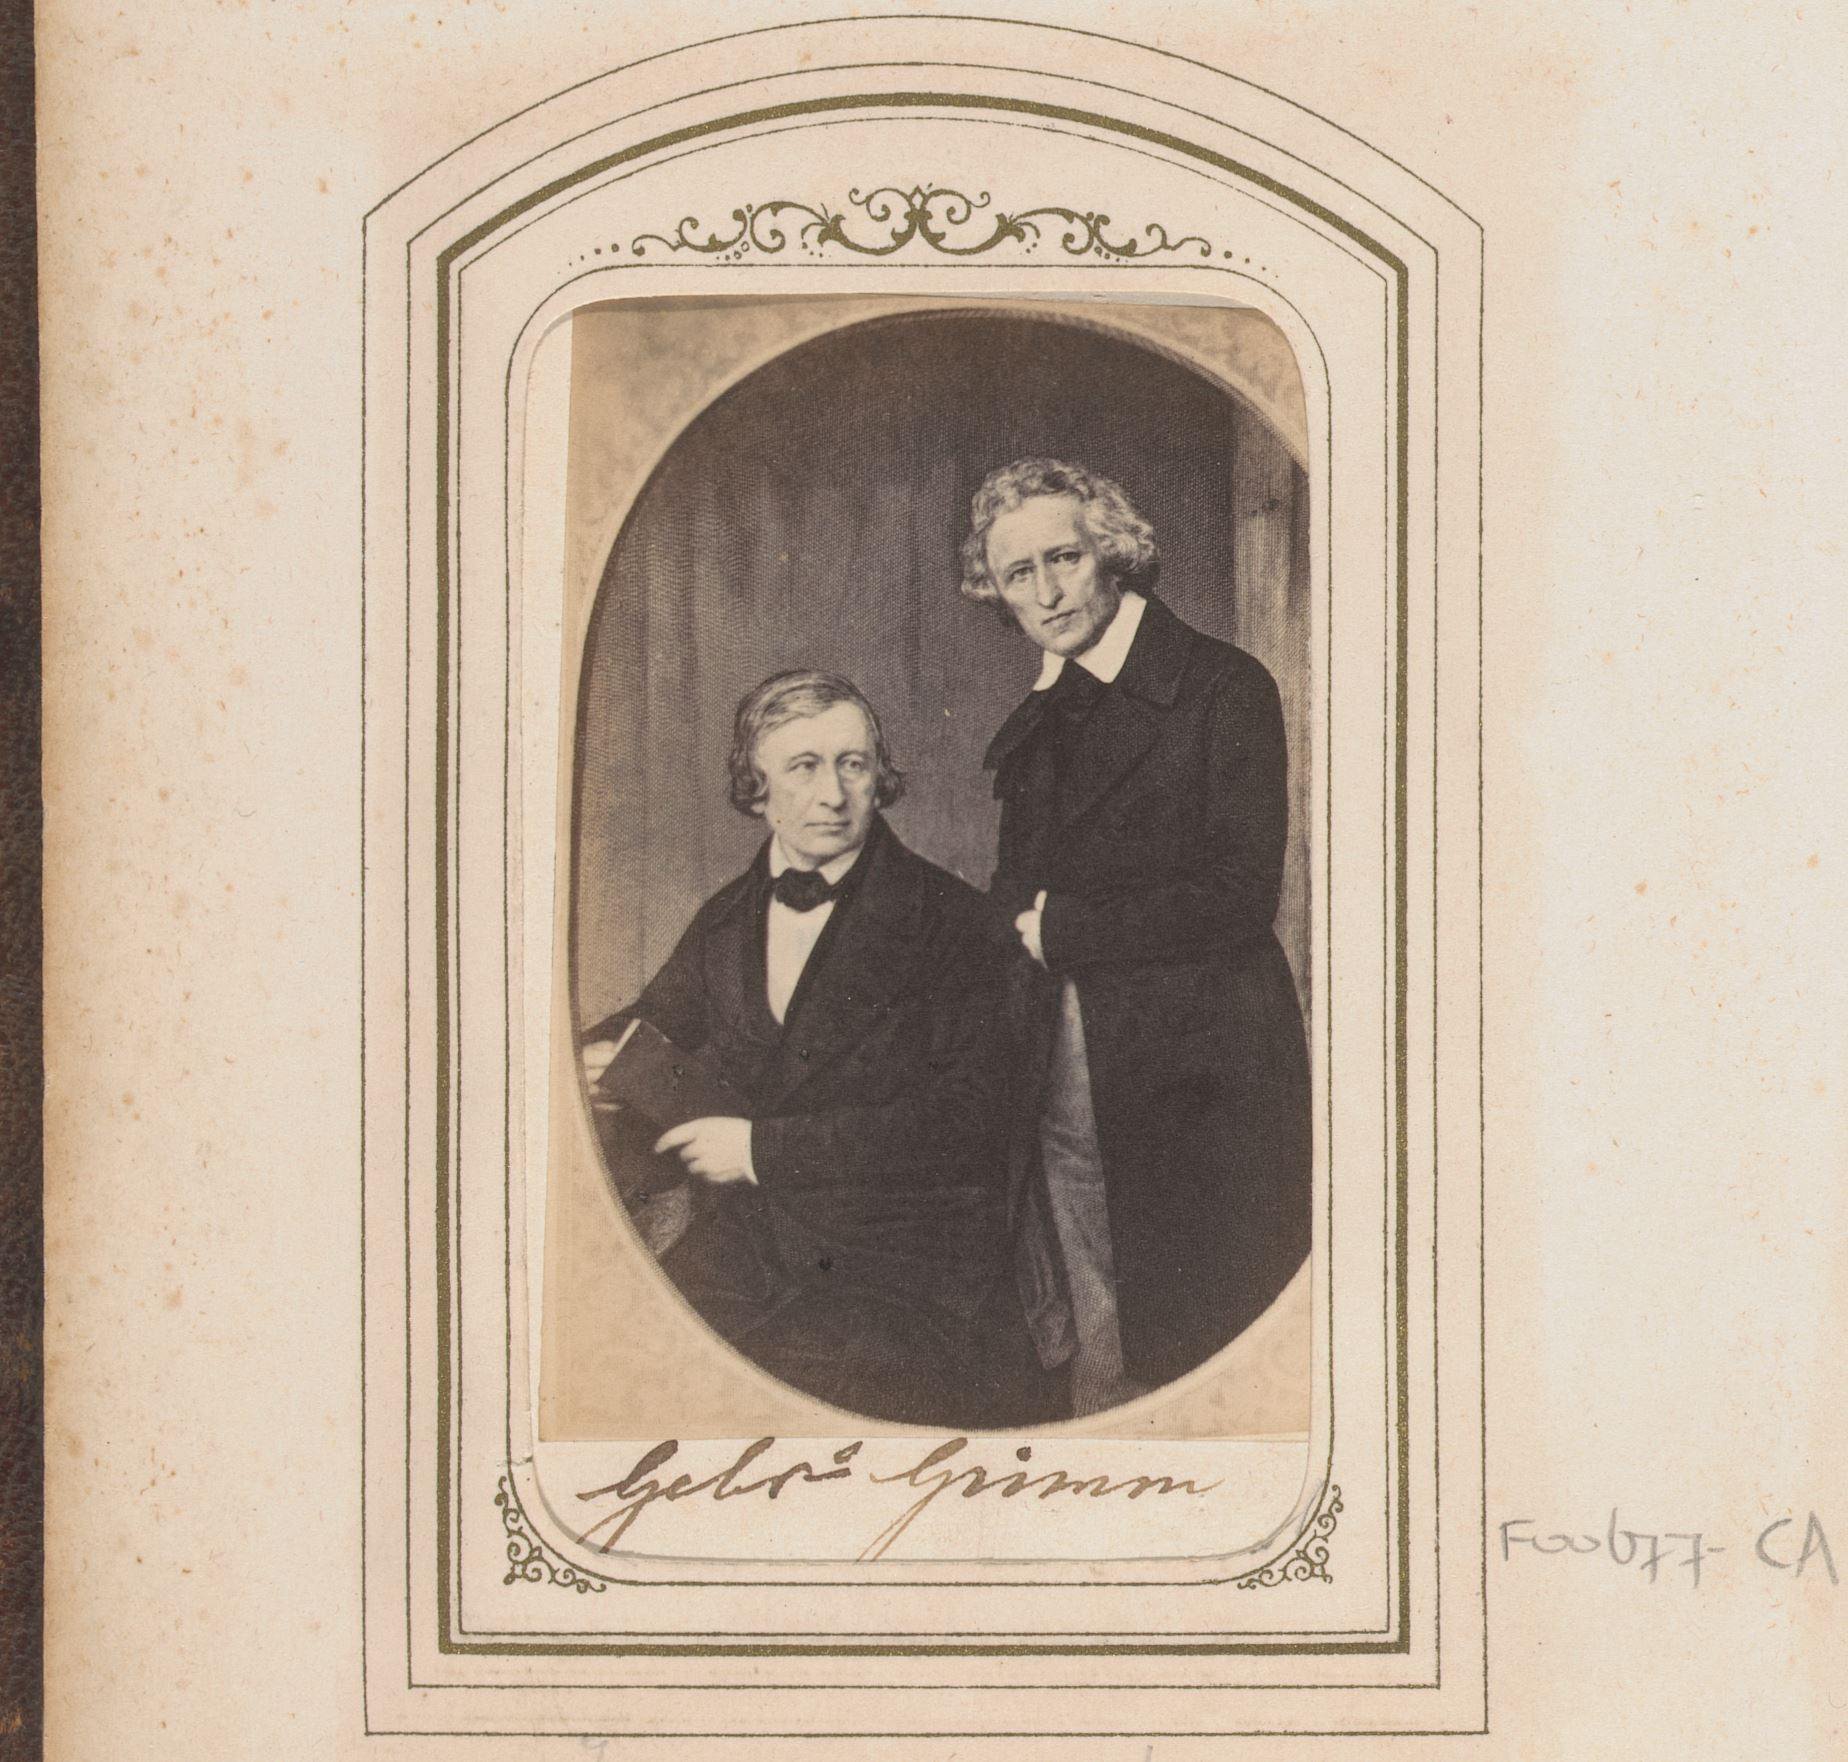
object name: album leaf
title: Fotoreproductie van een gegraveerd portret van de gebroeders Jacob en Wilhelm Grimm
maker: max pflaum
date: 1850-1900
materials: cardboard, photographic support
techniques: albumen print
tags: berlin, jacob ludwig karl grimm, historical persons, portrait of a writer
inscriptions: annotation: ‘Gebr Grimm’, inscription: ‘Photographisch Atelier/ MAX PFLAUM/ Berlin/ Leipziger-Strasse 44’, annotation: ‘Jacob 1785-1863/ Wilhelm 1786-1859’